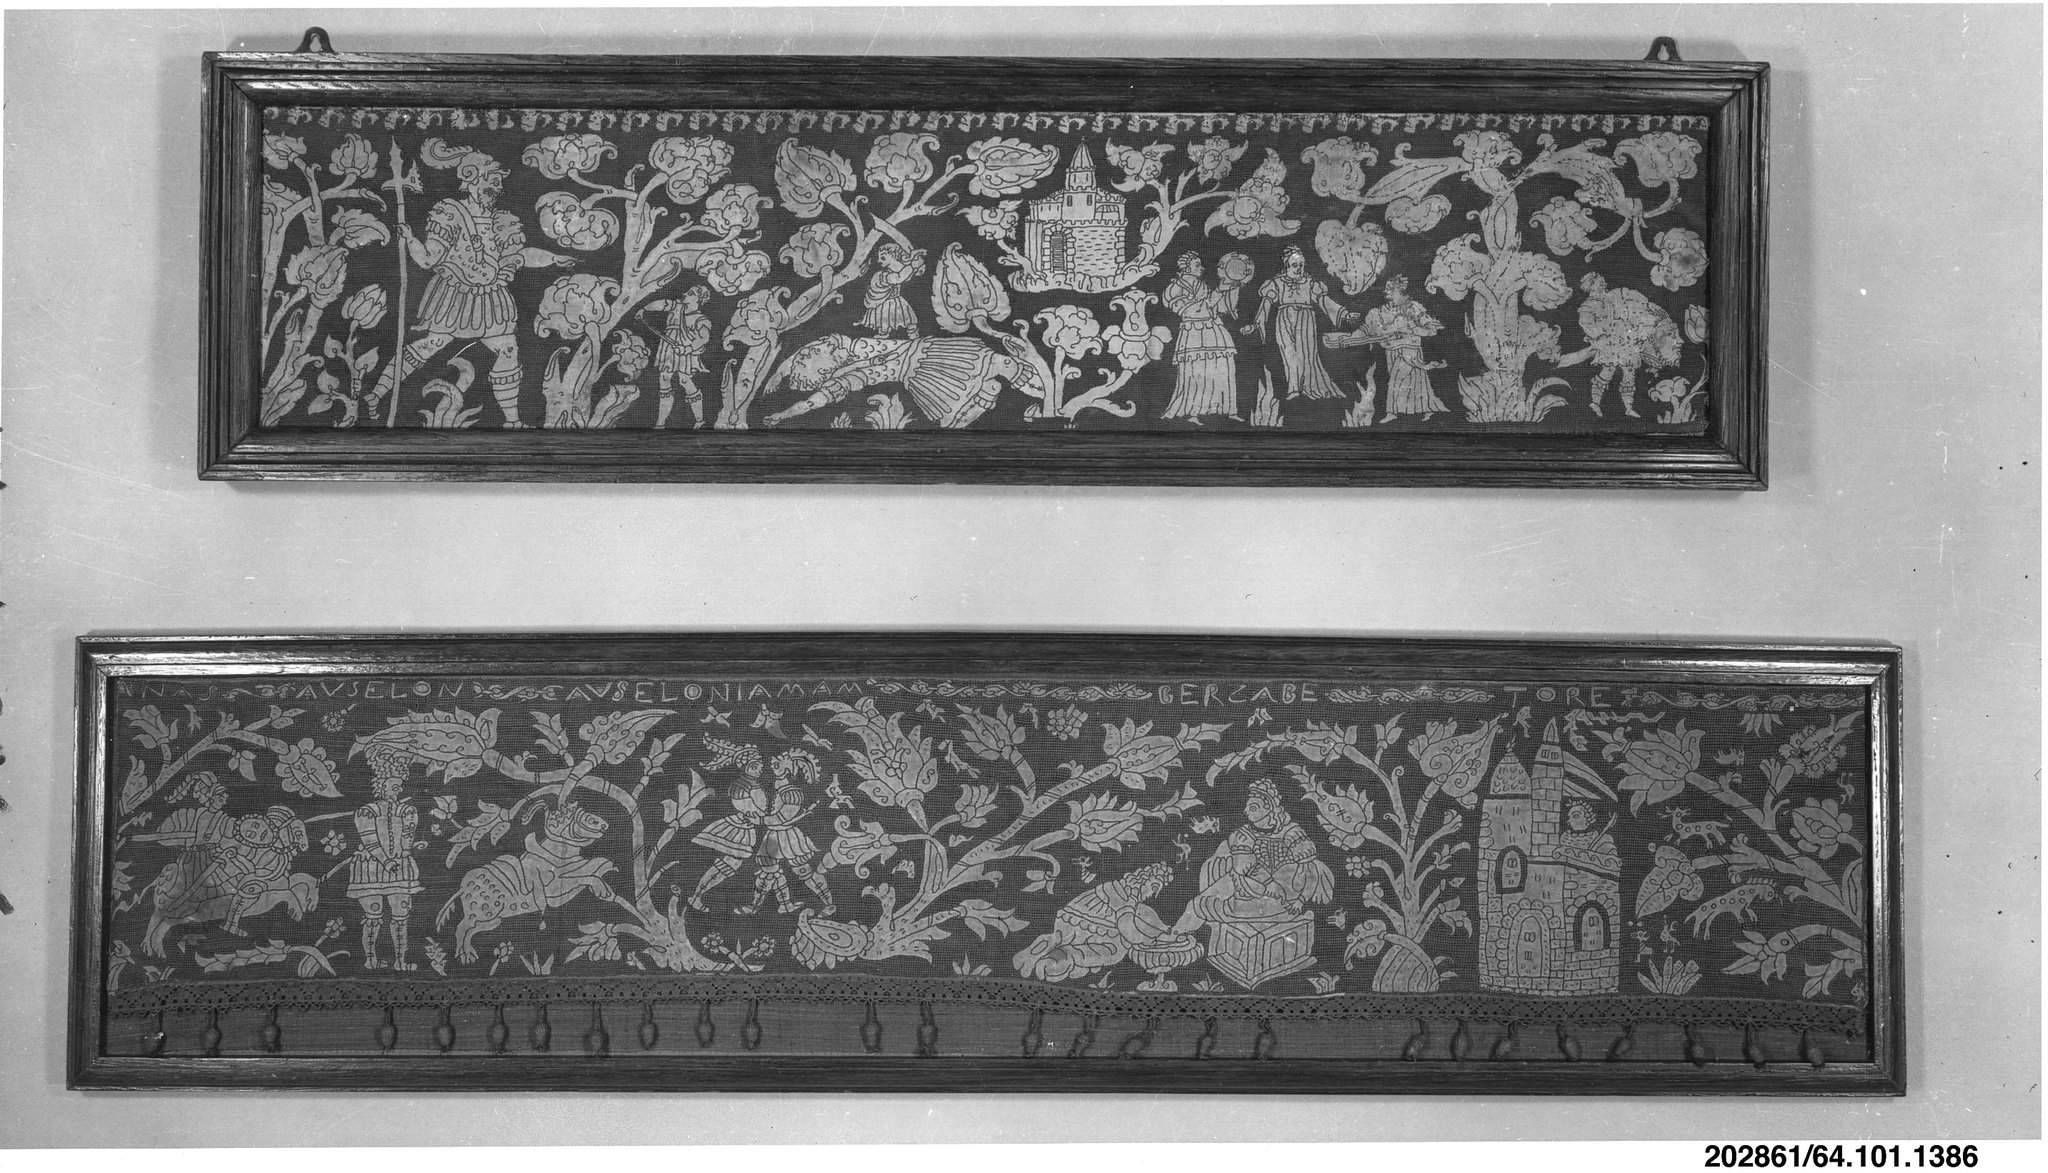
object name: band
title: Band with scenes from the Story of David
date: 1601-1650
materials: linen, silk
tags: men,horses,flowers,leaves,david